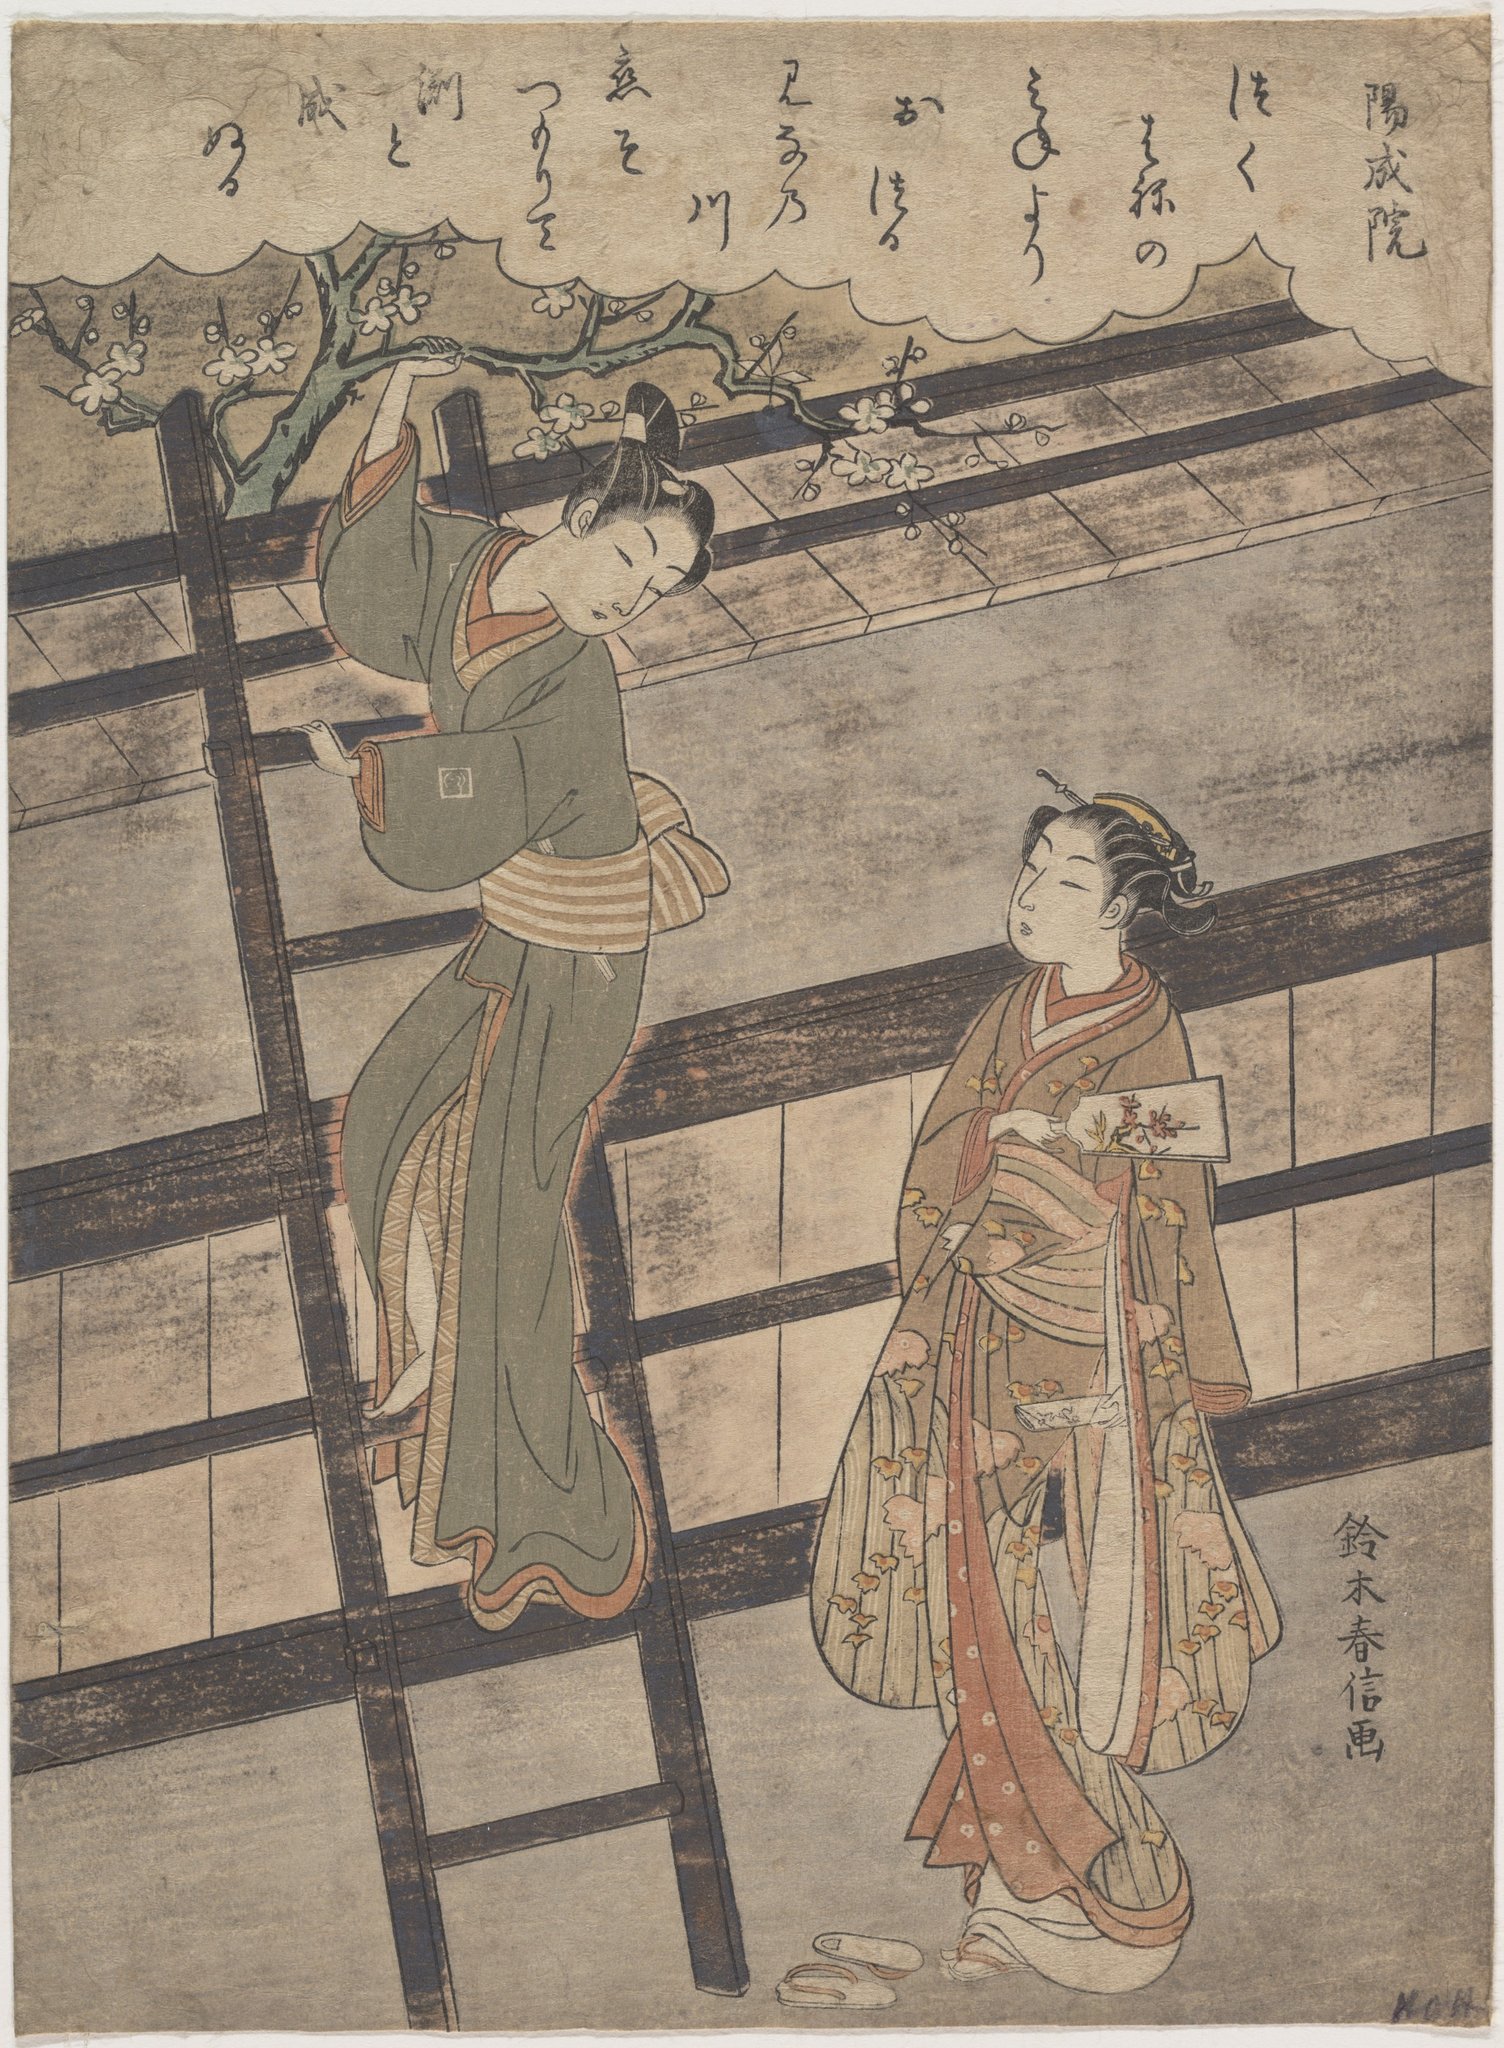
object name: print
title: Yozei no In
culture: japanese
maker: suzuki harunobu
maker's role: artist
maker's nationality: japanese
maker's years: 1725-1770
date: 1766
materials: ink, paper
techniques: woodblock print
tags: women,ladders